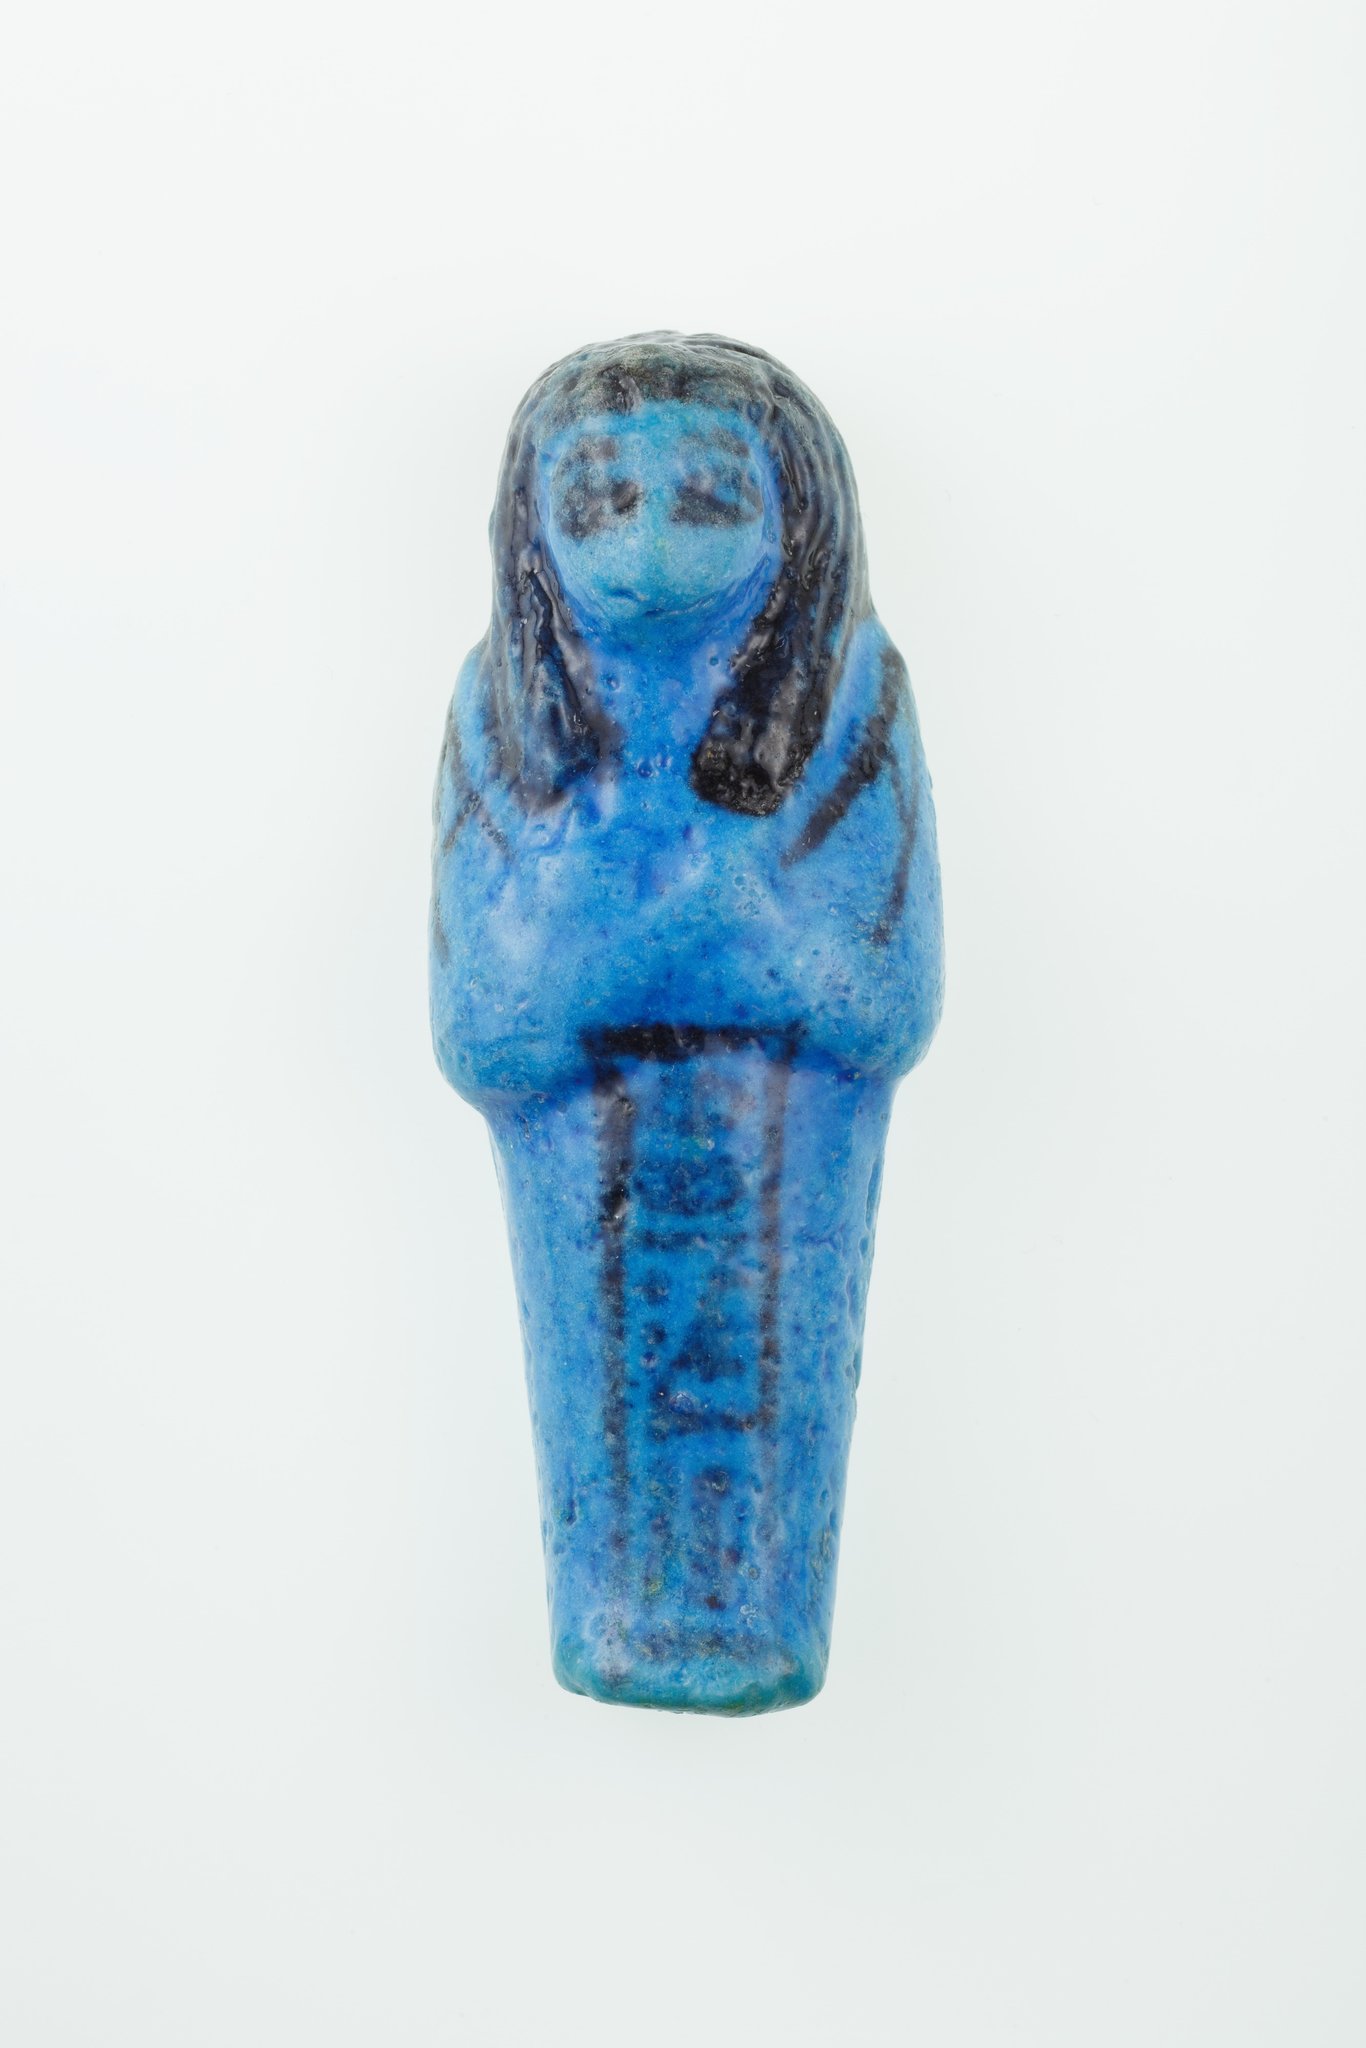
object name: shabti, worker, nauny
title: Worker Shabti of Nauny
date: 1050 BCE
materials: faience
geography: egypt